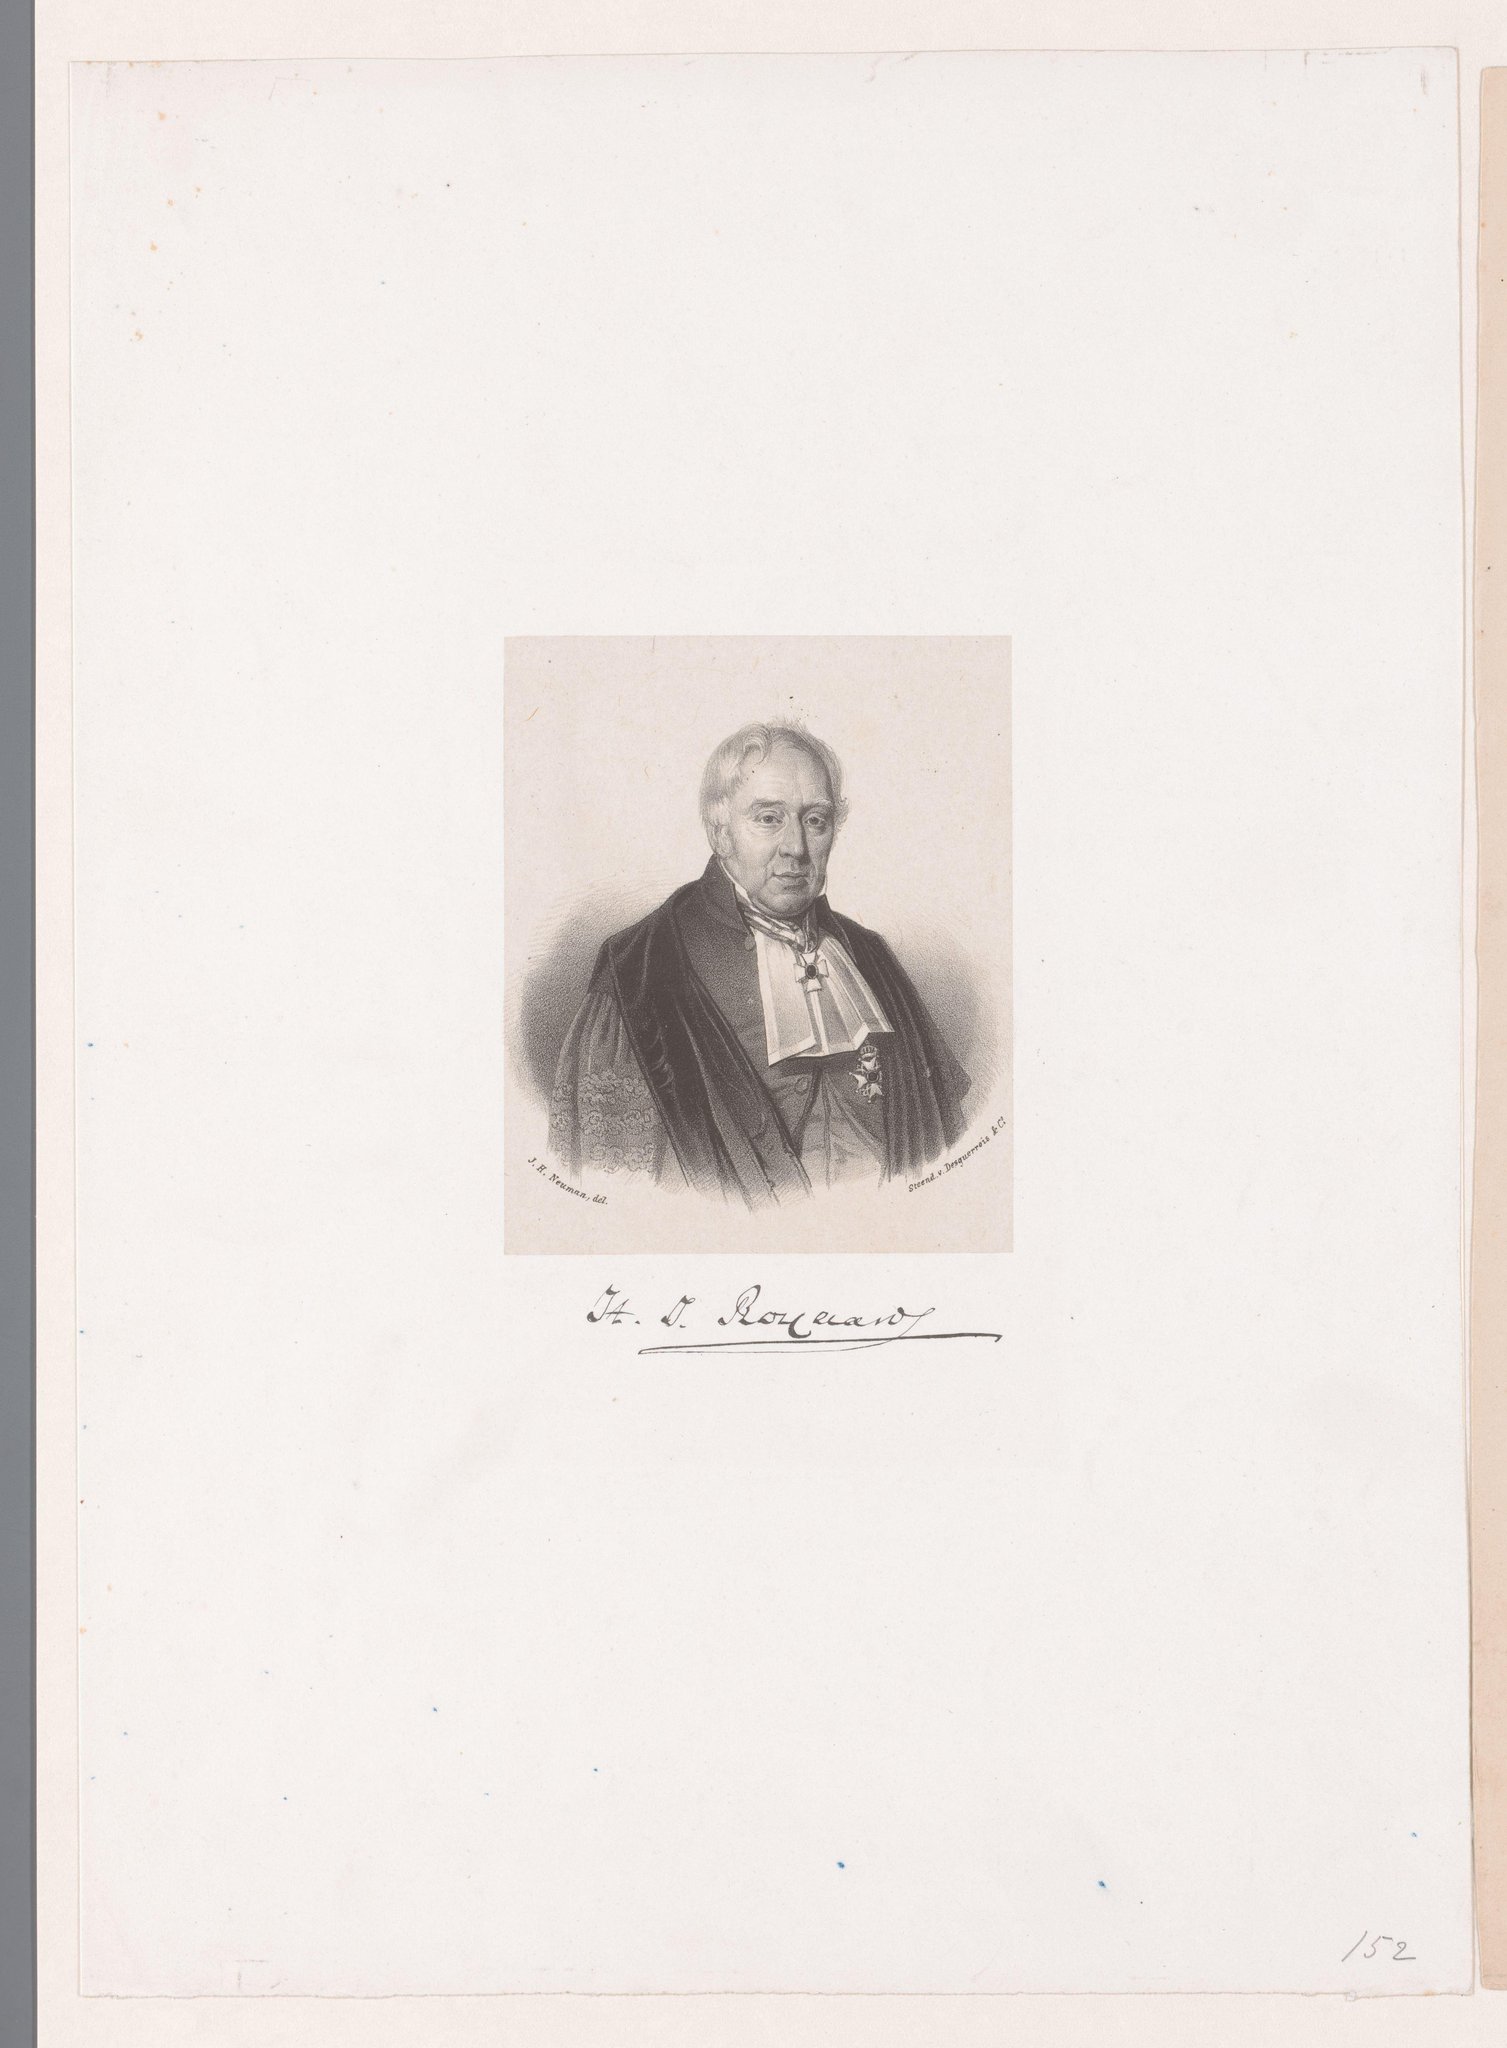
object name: print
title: Portret van Herman Johan Royaards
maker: johan heinrich neuman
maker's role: draughtsman, painter, print maker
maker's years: 1819-1898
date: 1827-1907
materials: paper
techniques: lithograph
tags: utrecht, herman johan royaards, historical persons (+ head (and shoulders) (portrait)), knighthood order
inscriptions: collector's mark: Lugt 2228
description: De geportretteerde draagt een toga en bef. Hij draagt een ridderorde om zijn hals en op zijn borst. Onder het portret zijn signatuur.